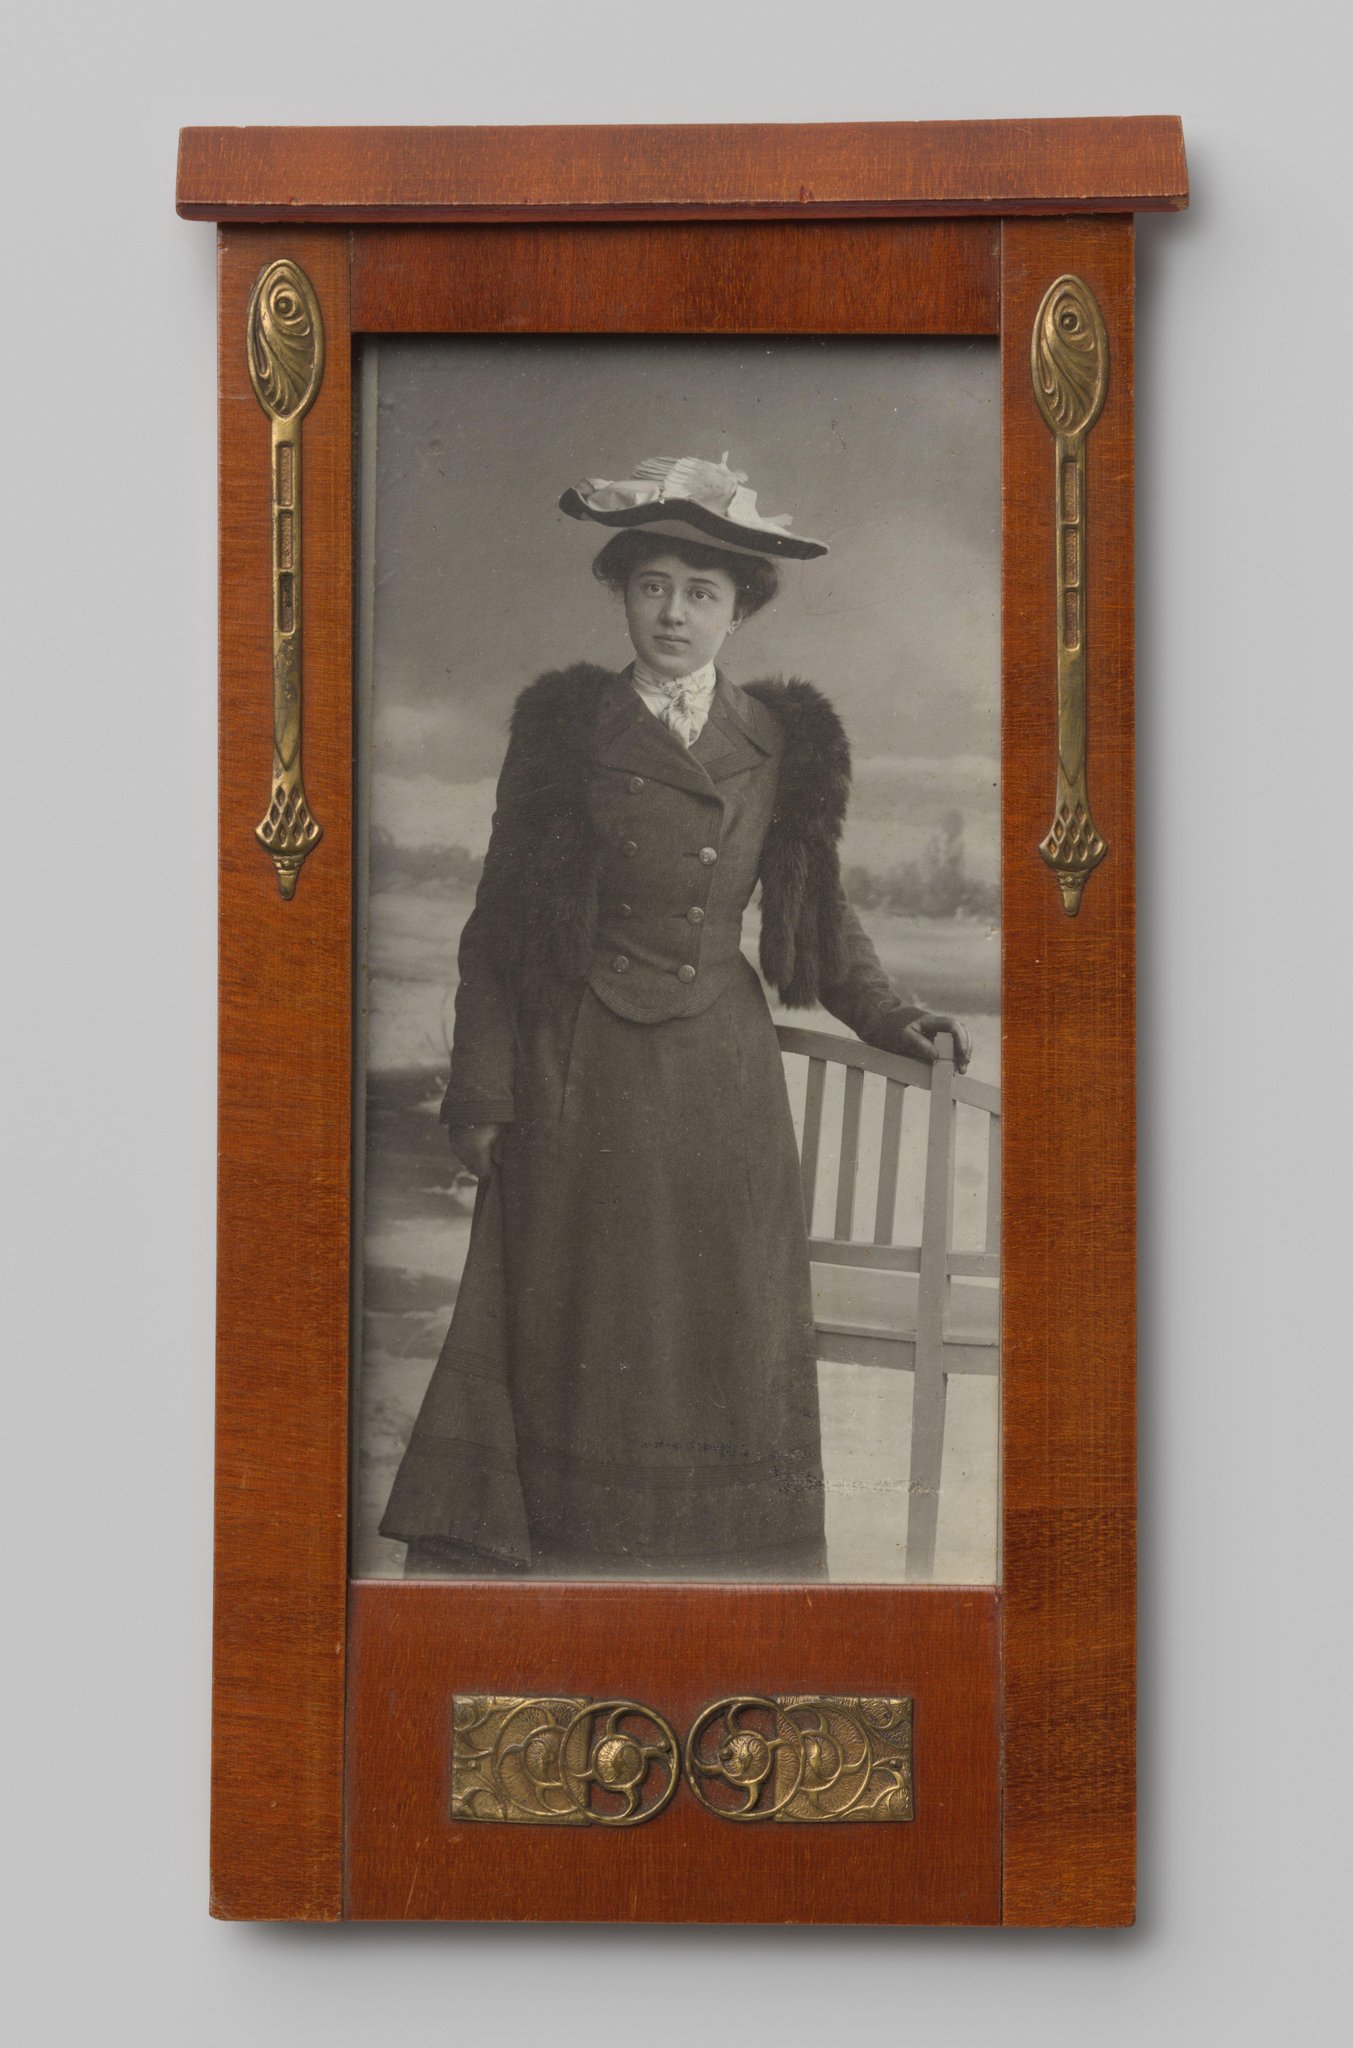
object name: frame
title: Portret van een onbekende vrouw met hoed, leunend op een bank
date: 1900-1920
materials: paper, cardboard, glass, metal, wood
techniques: gelatin silver print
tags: bench, head-gear: hat, anonymous historical person portrayed - bb - woman